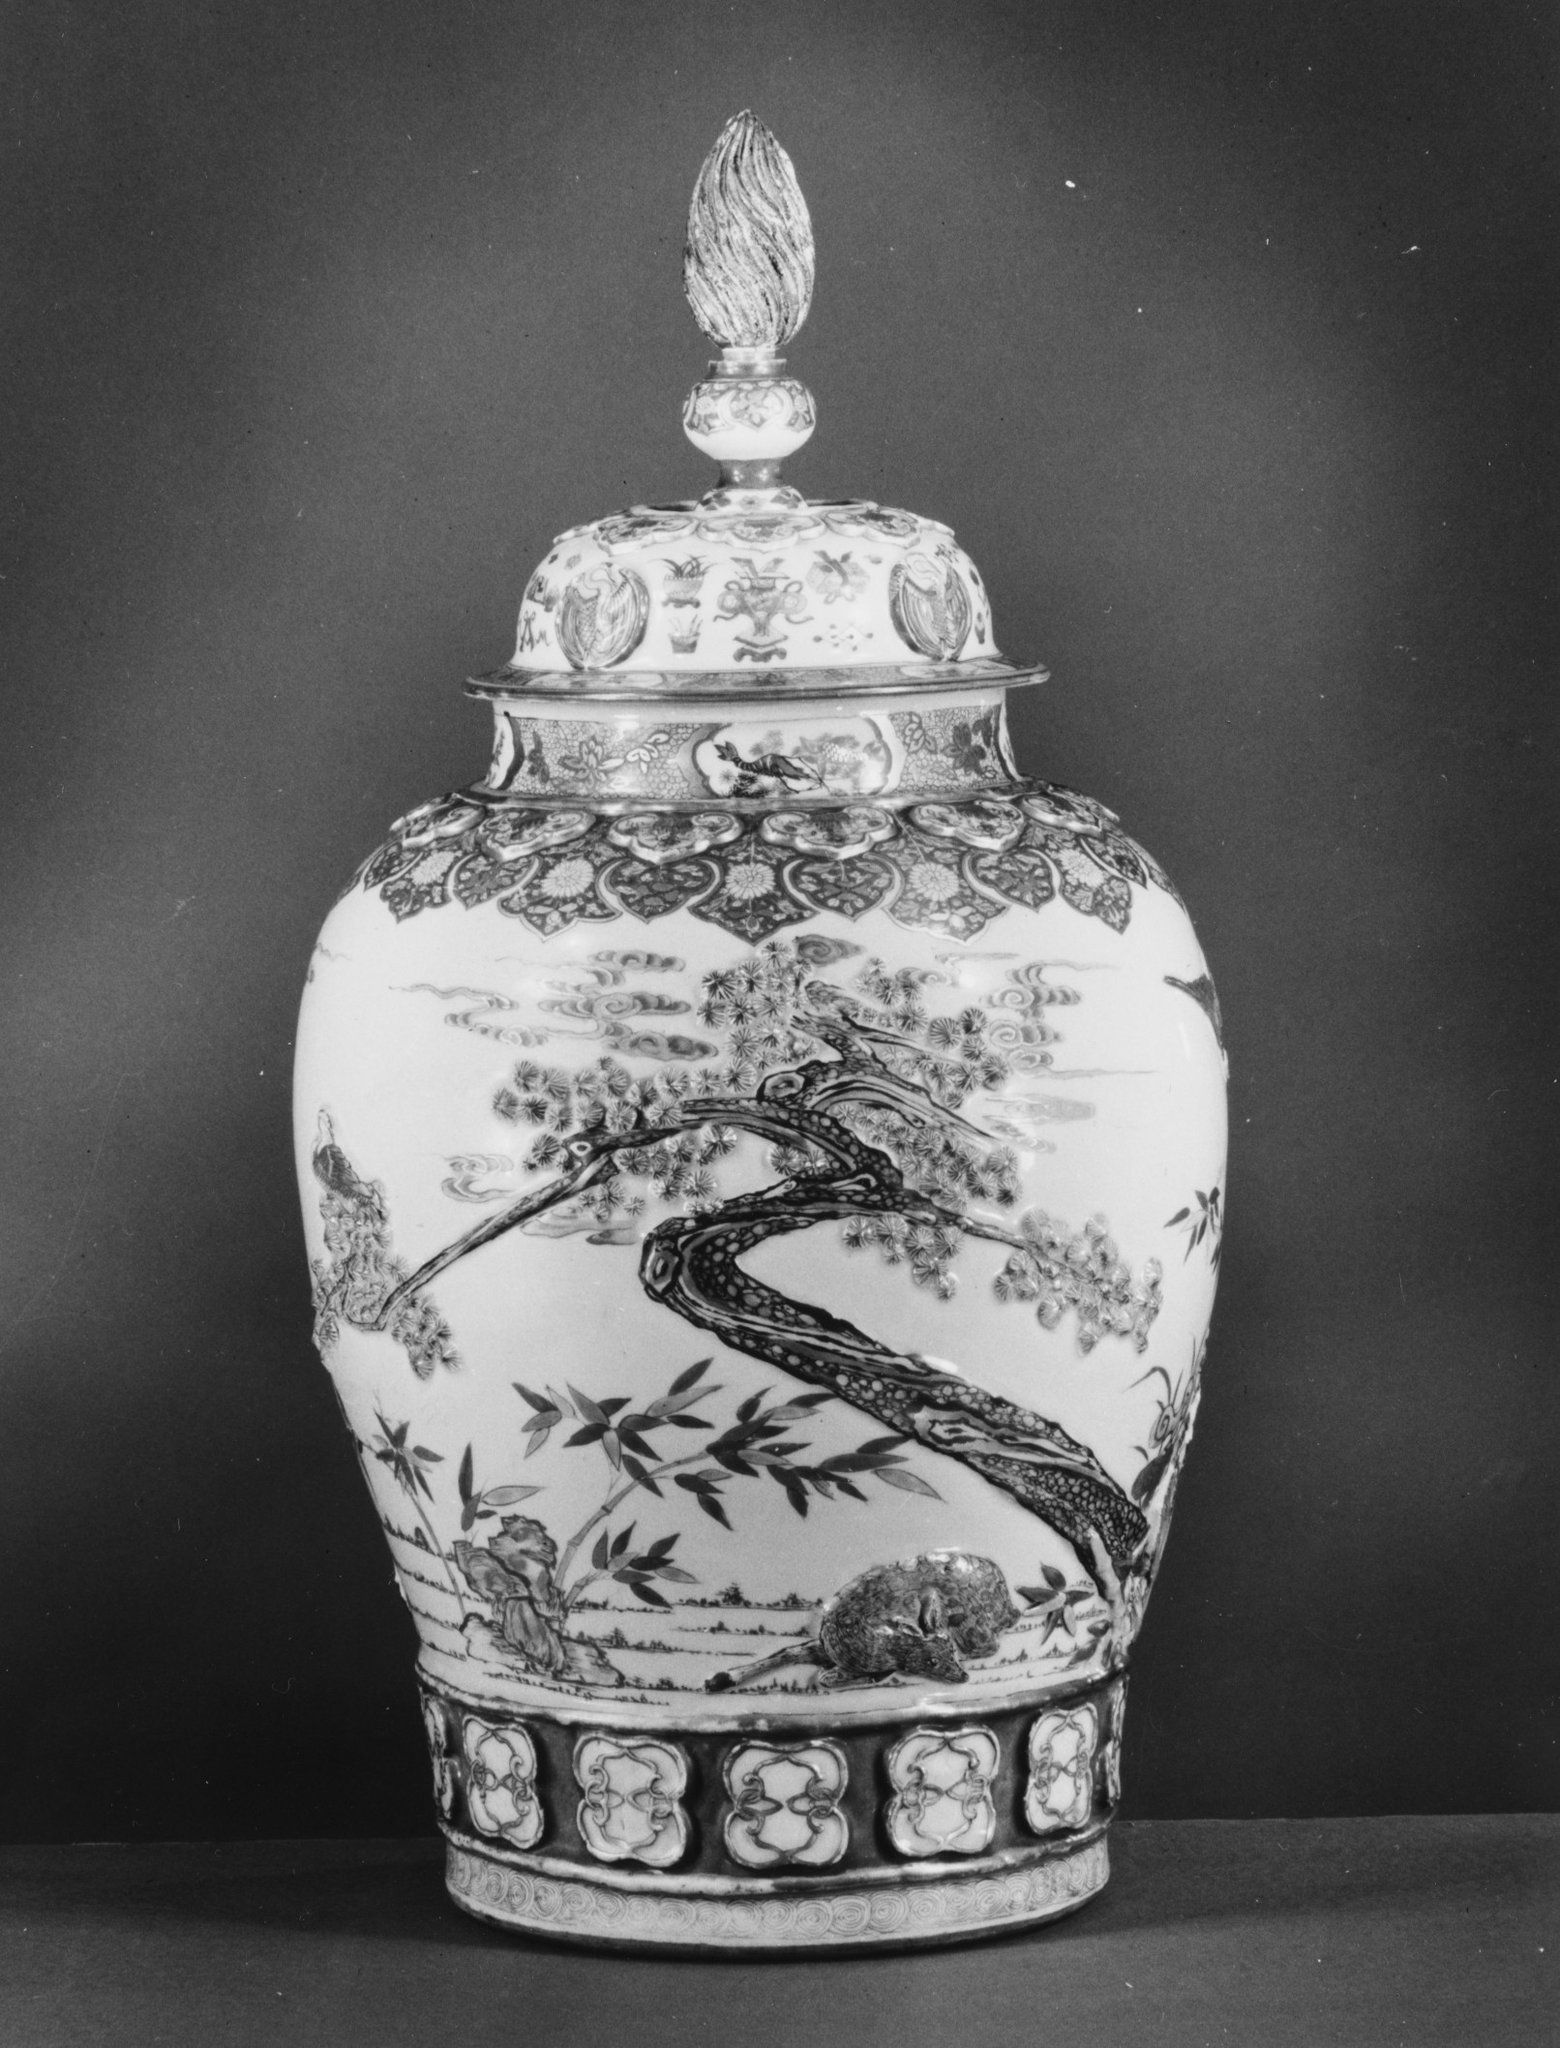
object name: hearth jar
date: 1750-1790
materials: porcelain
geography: china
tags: trees